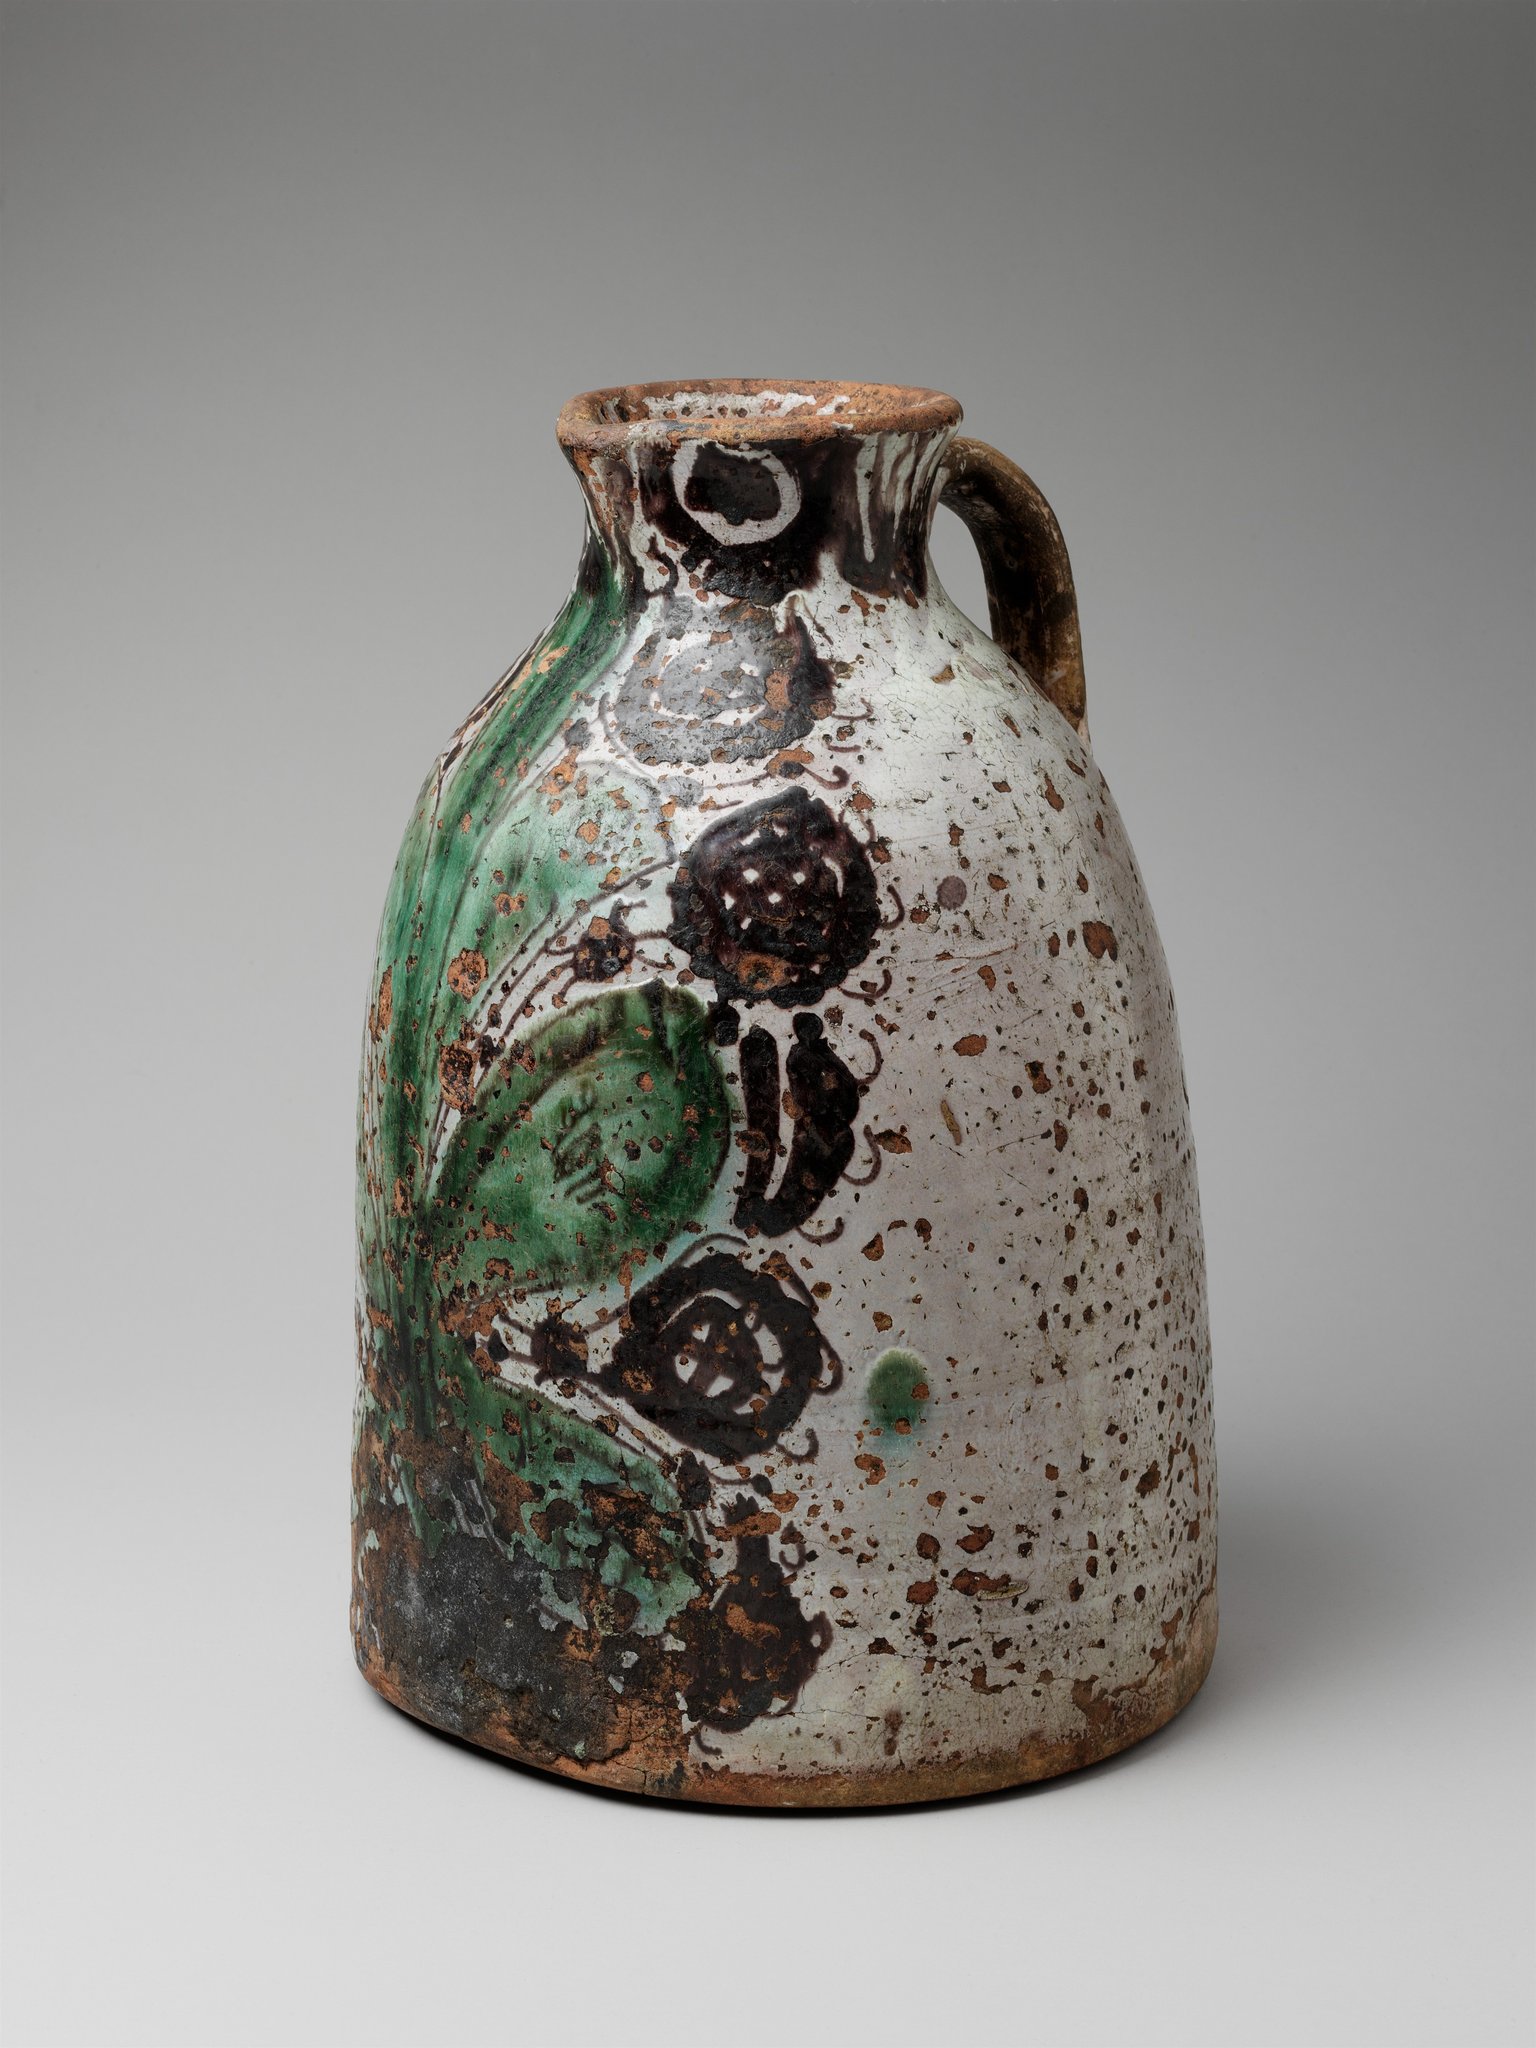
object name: jug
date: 1401-1500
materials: earthenware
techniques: glazing